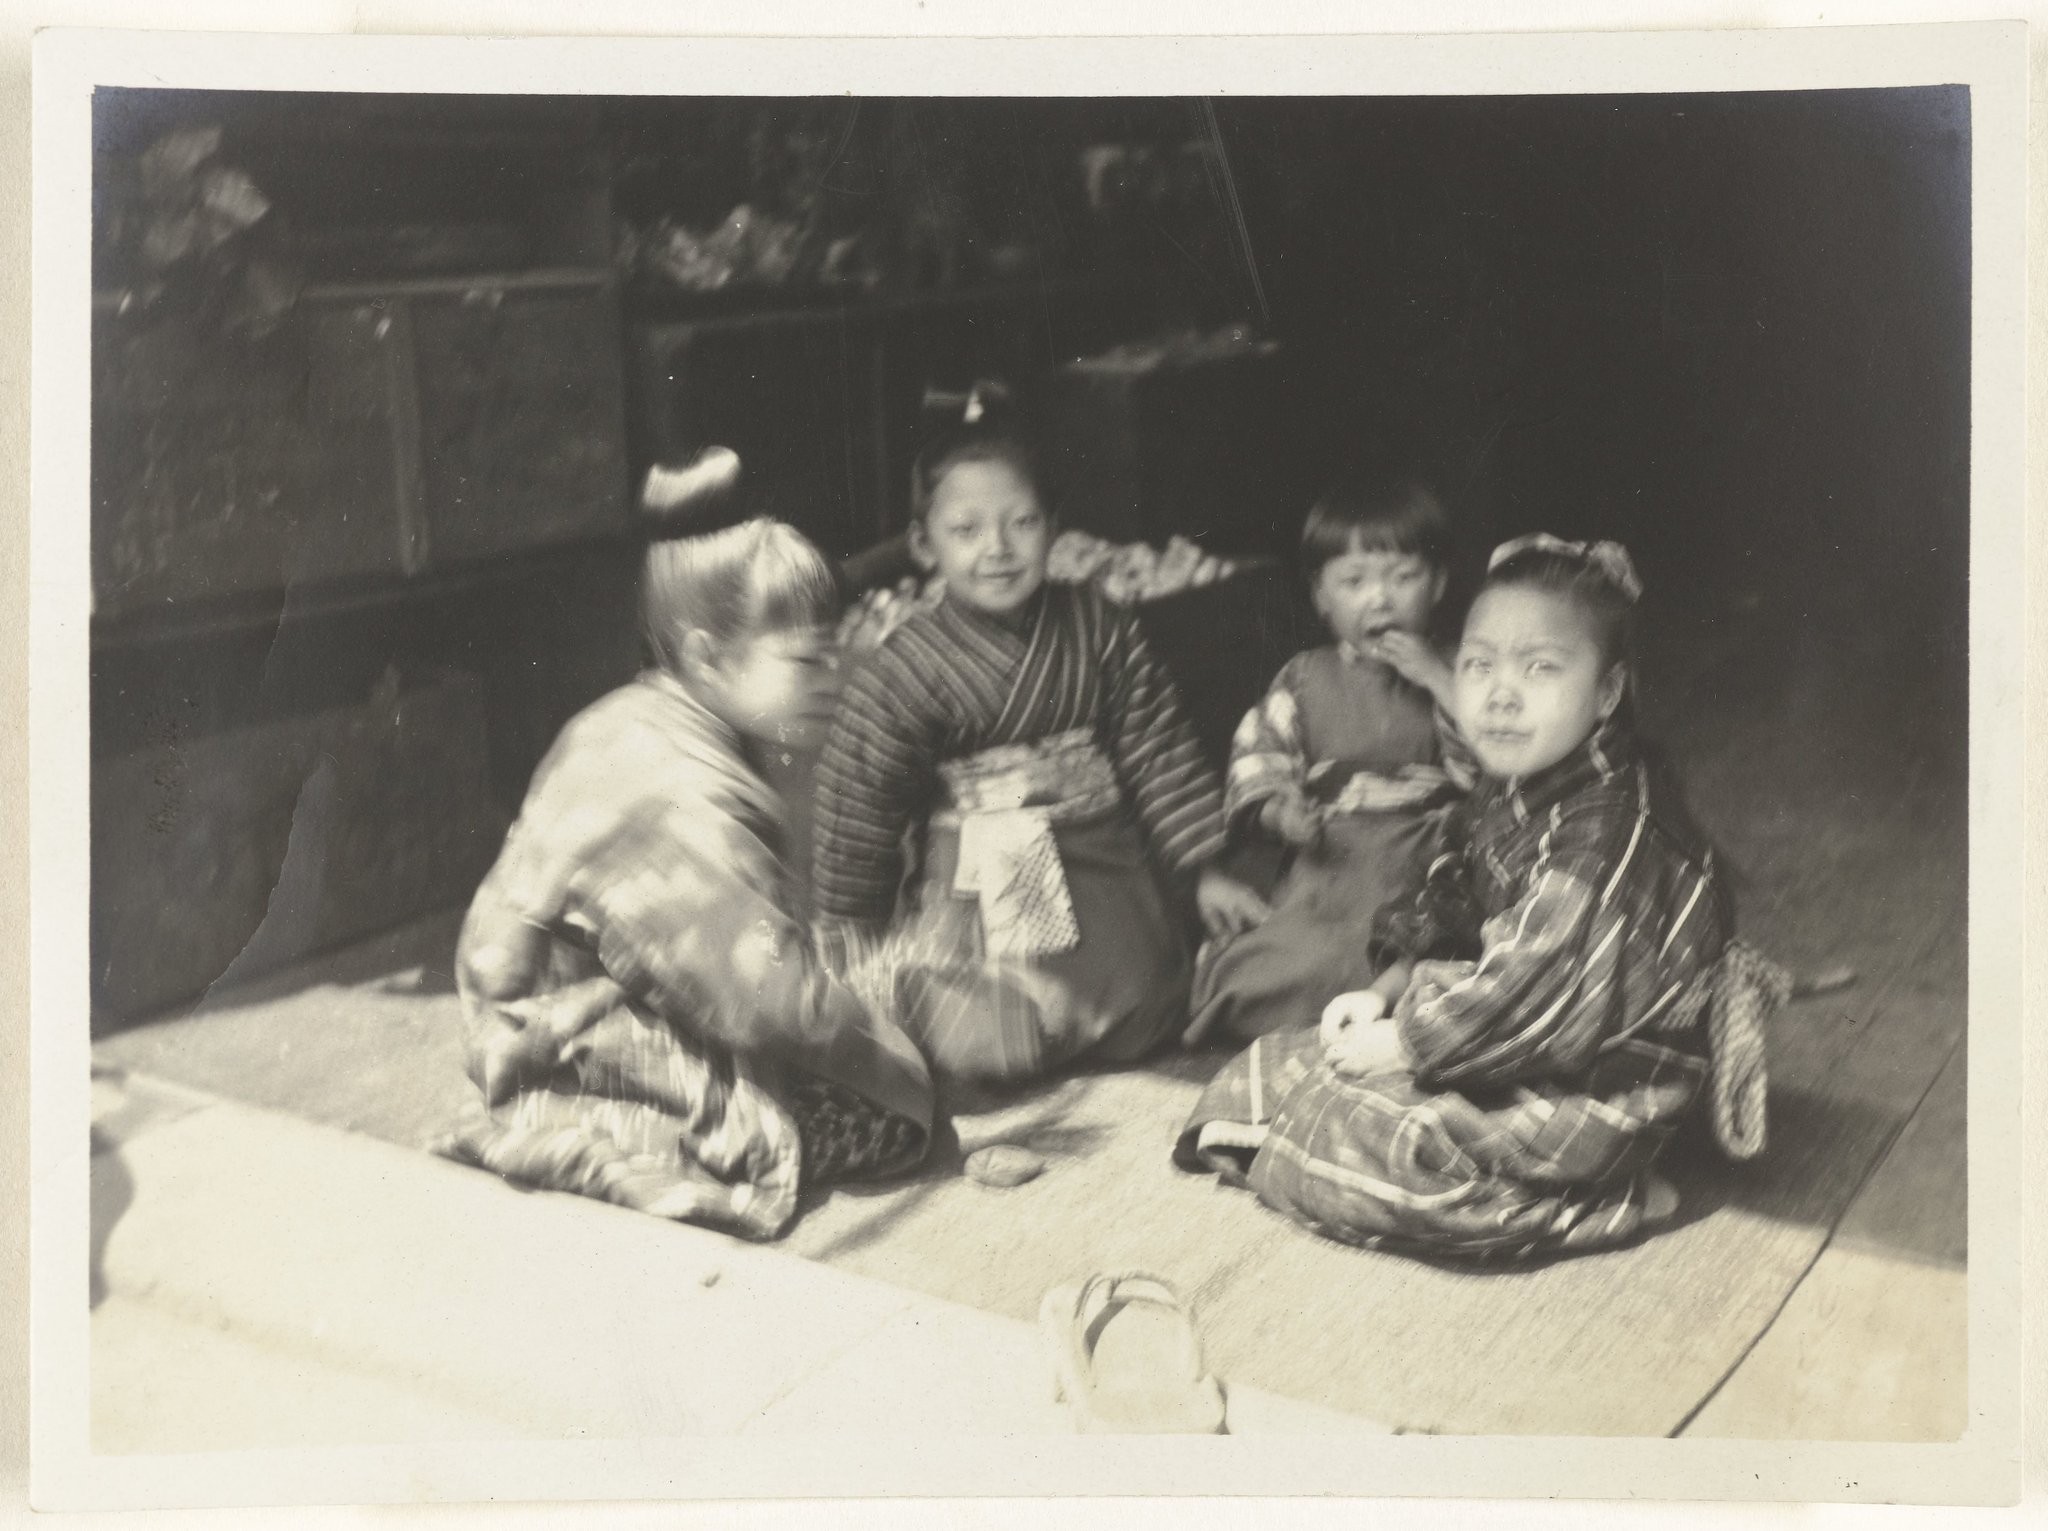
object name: photograph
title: Japanse kinderen spelen een spel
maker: geldolph adriaan kessler (dolph)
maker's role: fotograaf, industrieel, voetballer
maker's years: 1884-1945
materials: cardboard, photographic support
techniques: gelatin silver print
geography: japan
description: Japanse kinderen spelen een spel in een deuropening. Onderdeel van het fotoalbum van Dolph Kessler met opnamen die hij maakte tijdens zijn verblijf in Engeland en op een wereldreis die hij als secretaris van Henri Deterding (directeur Koninklijke Olie) ondernam naar Nederlands-Indië, Japan, China en de Verenigde Staten, tussen 1906 en 1908.